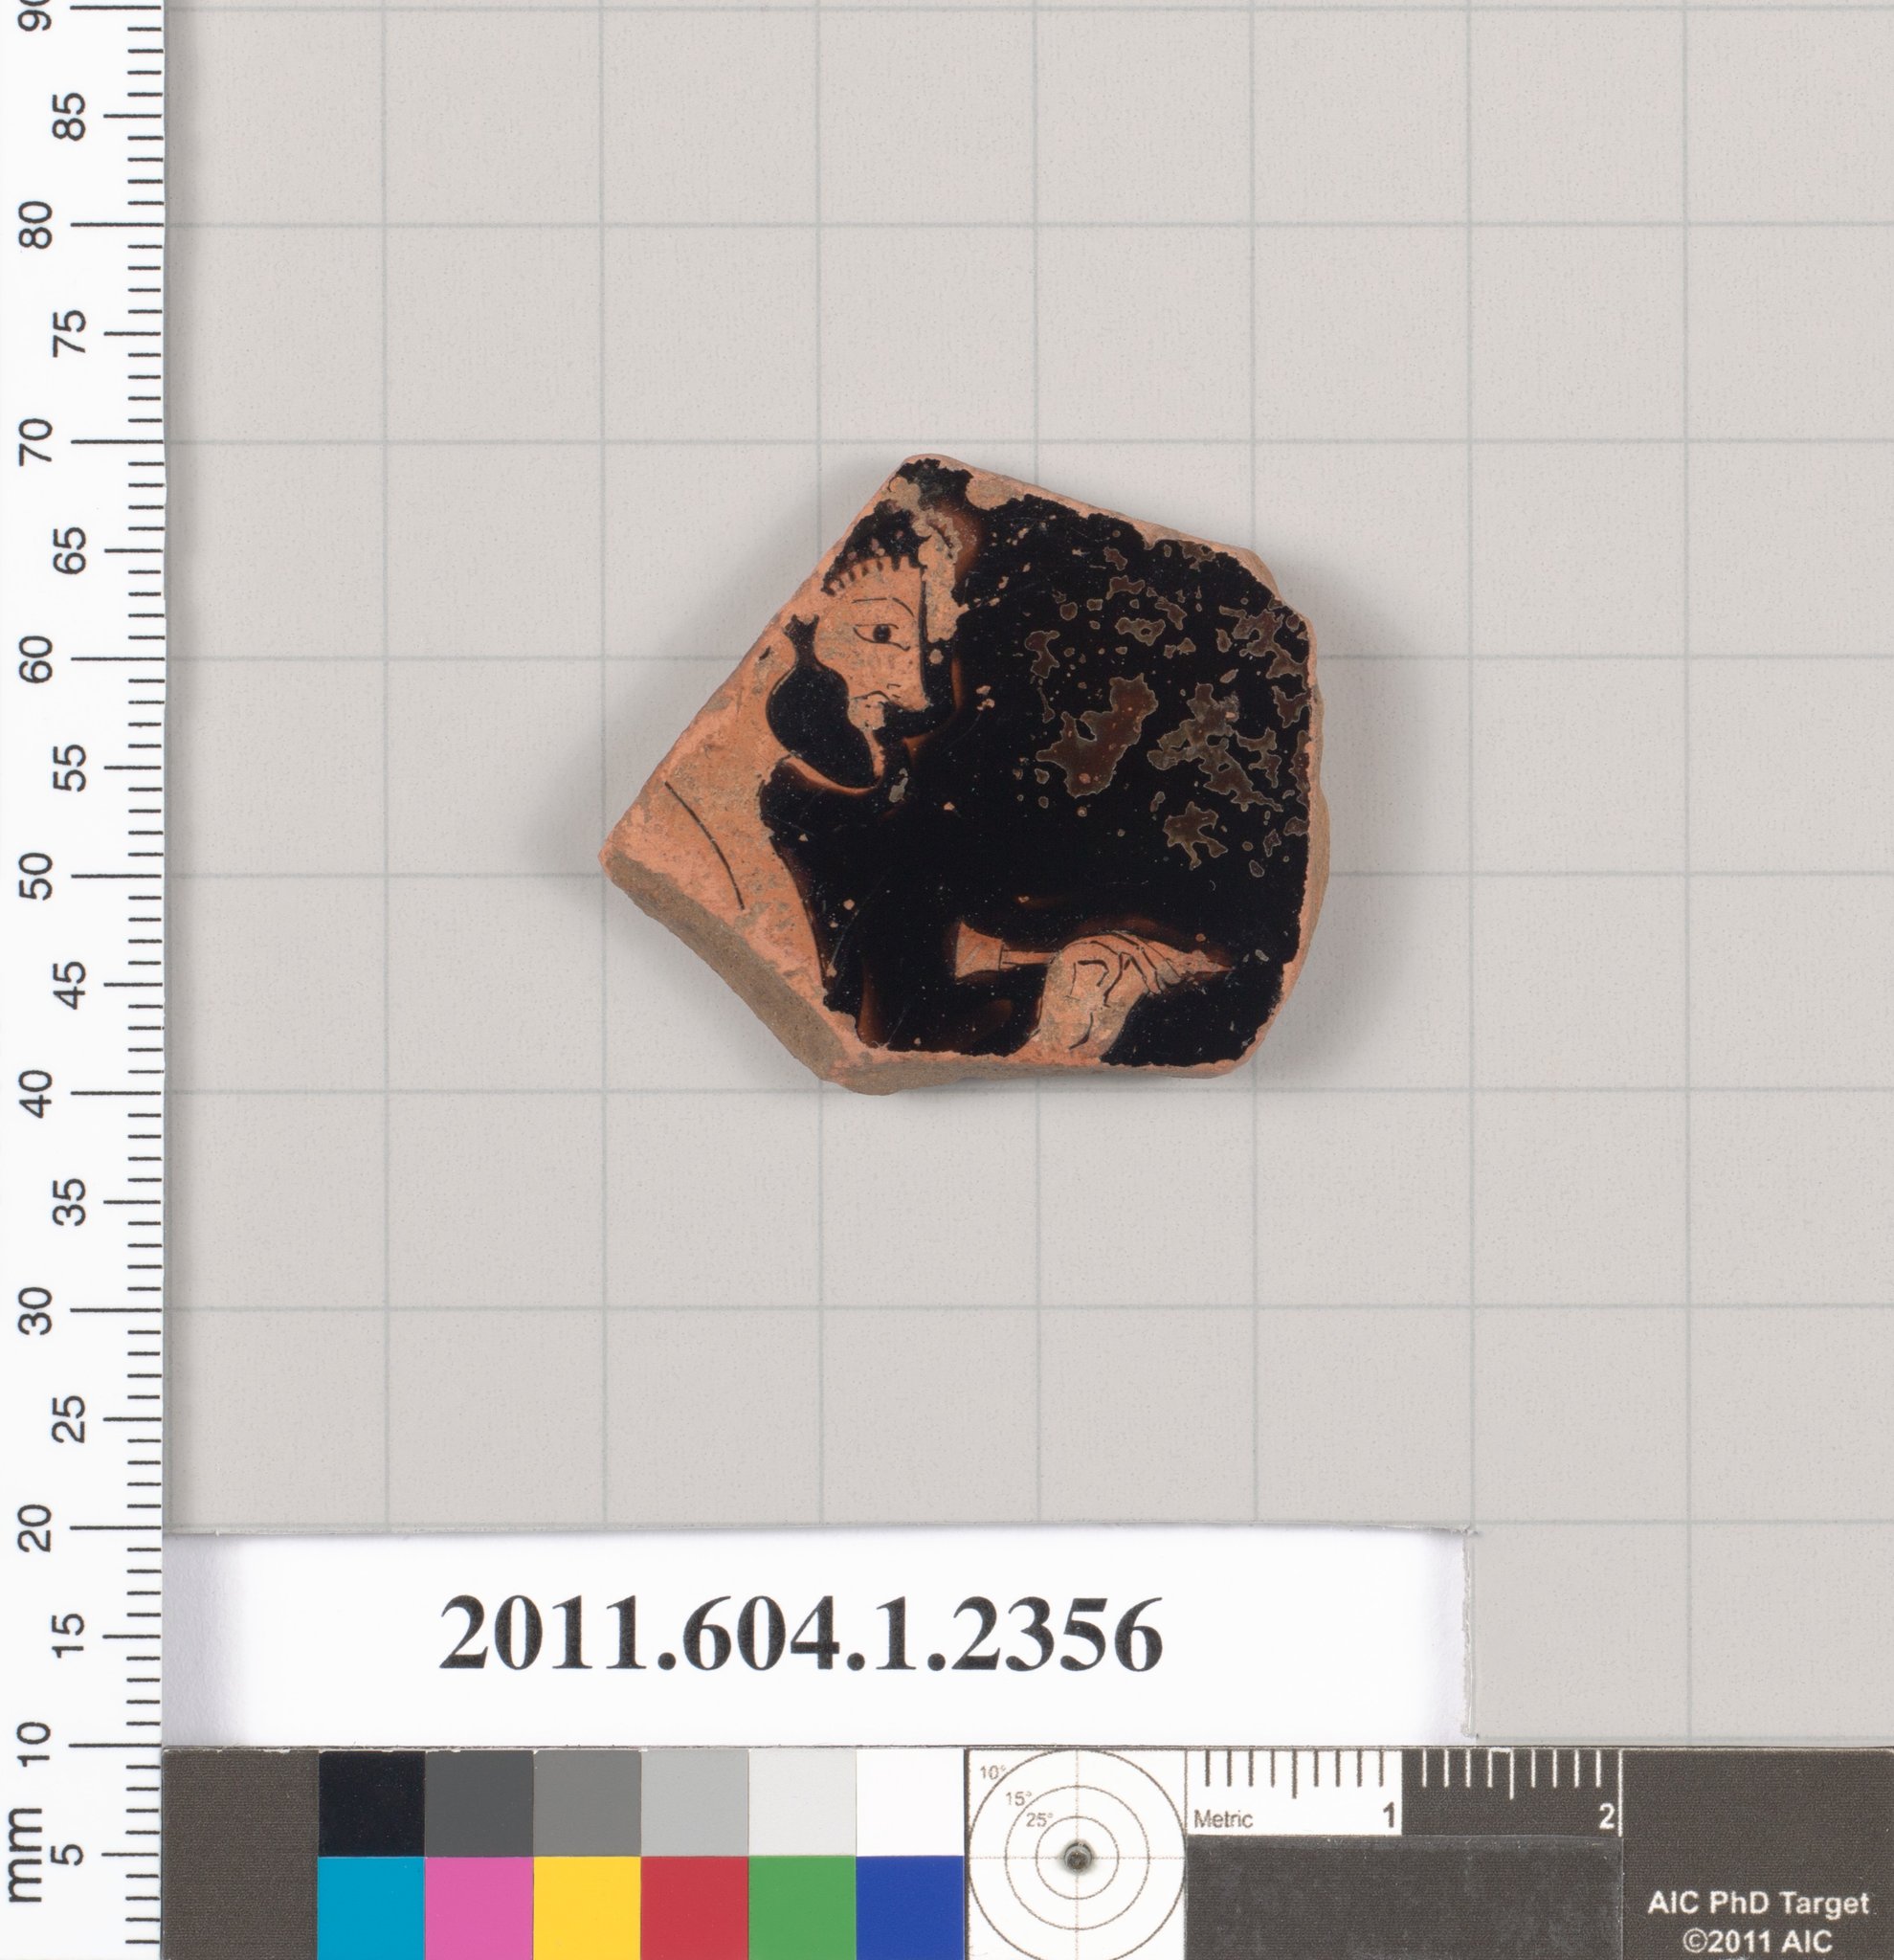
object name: kylix fragment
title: Terracotta fragment of a kylix (drinking cup)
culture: greek, attic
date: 510-500 BCE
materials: terracotta